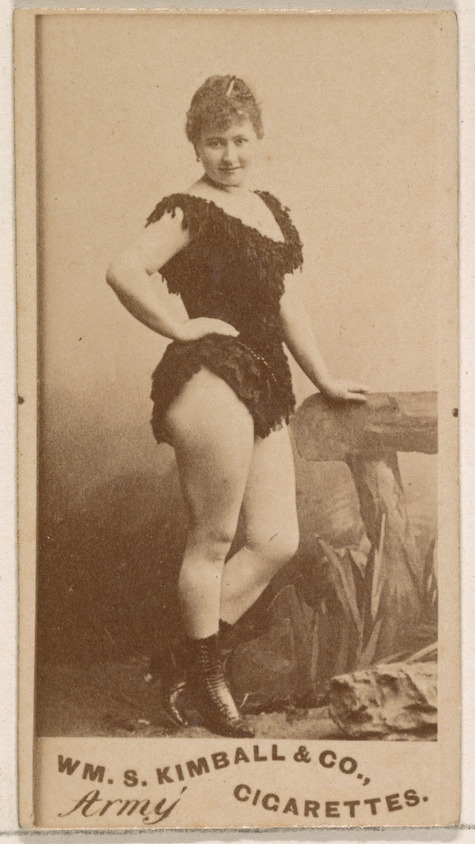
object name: photograph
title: Miss Army, from the Actresses series (N203) issued by Wm. S. Kimball & Co.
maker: william s. kimball & company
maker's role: publisher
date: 1889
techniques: color lithograph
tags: portraits,women,actresses